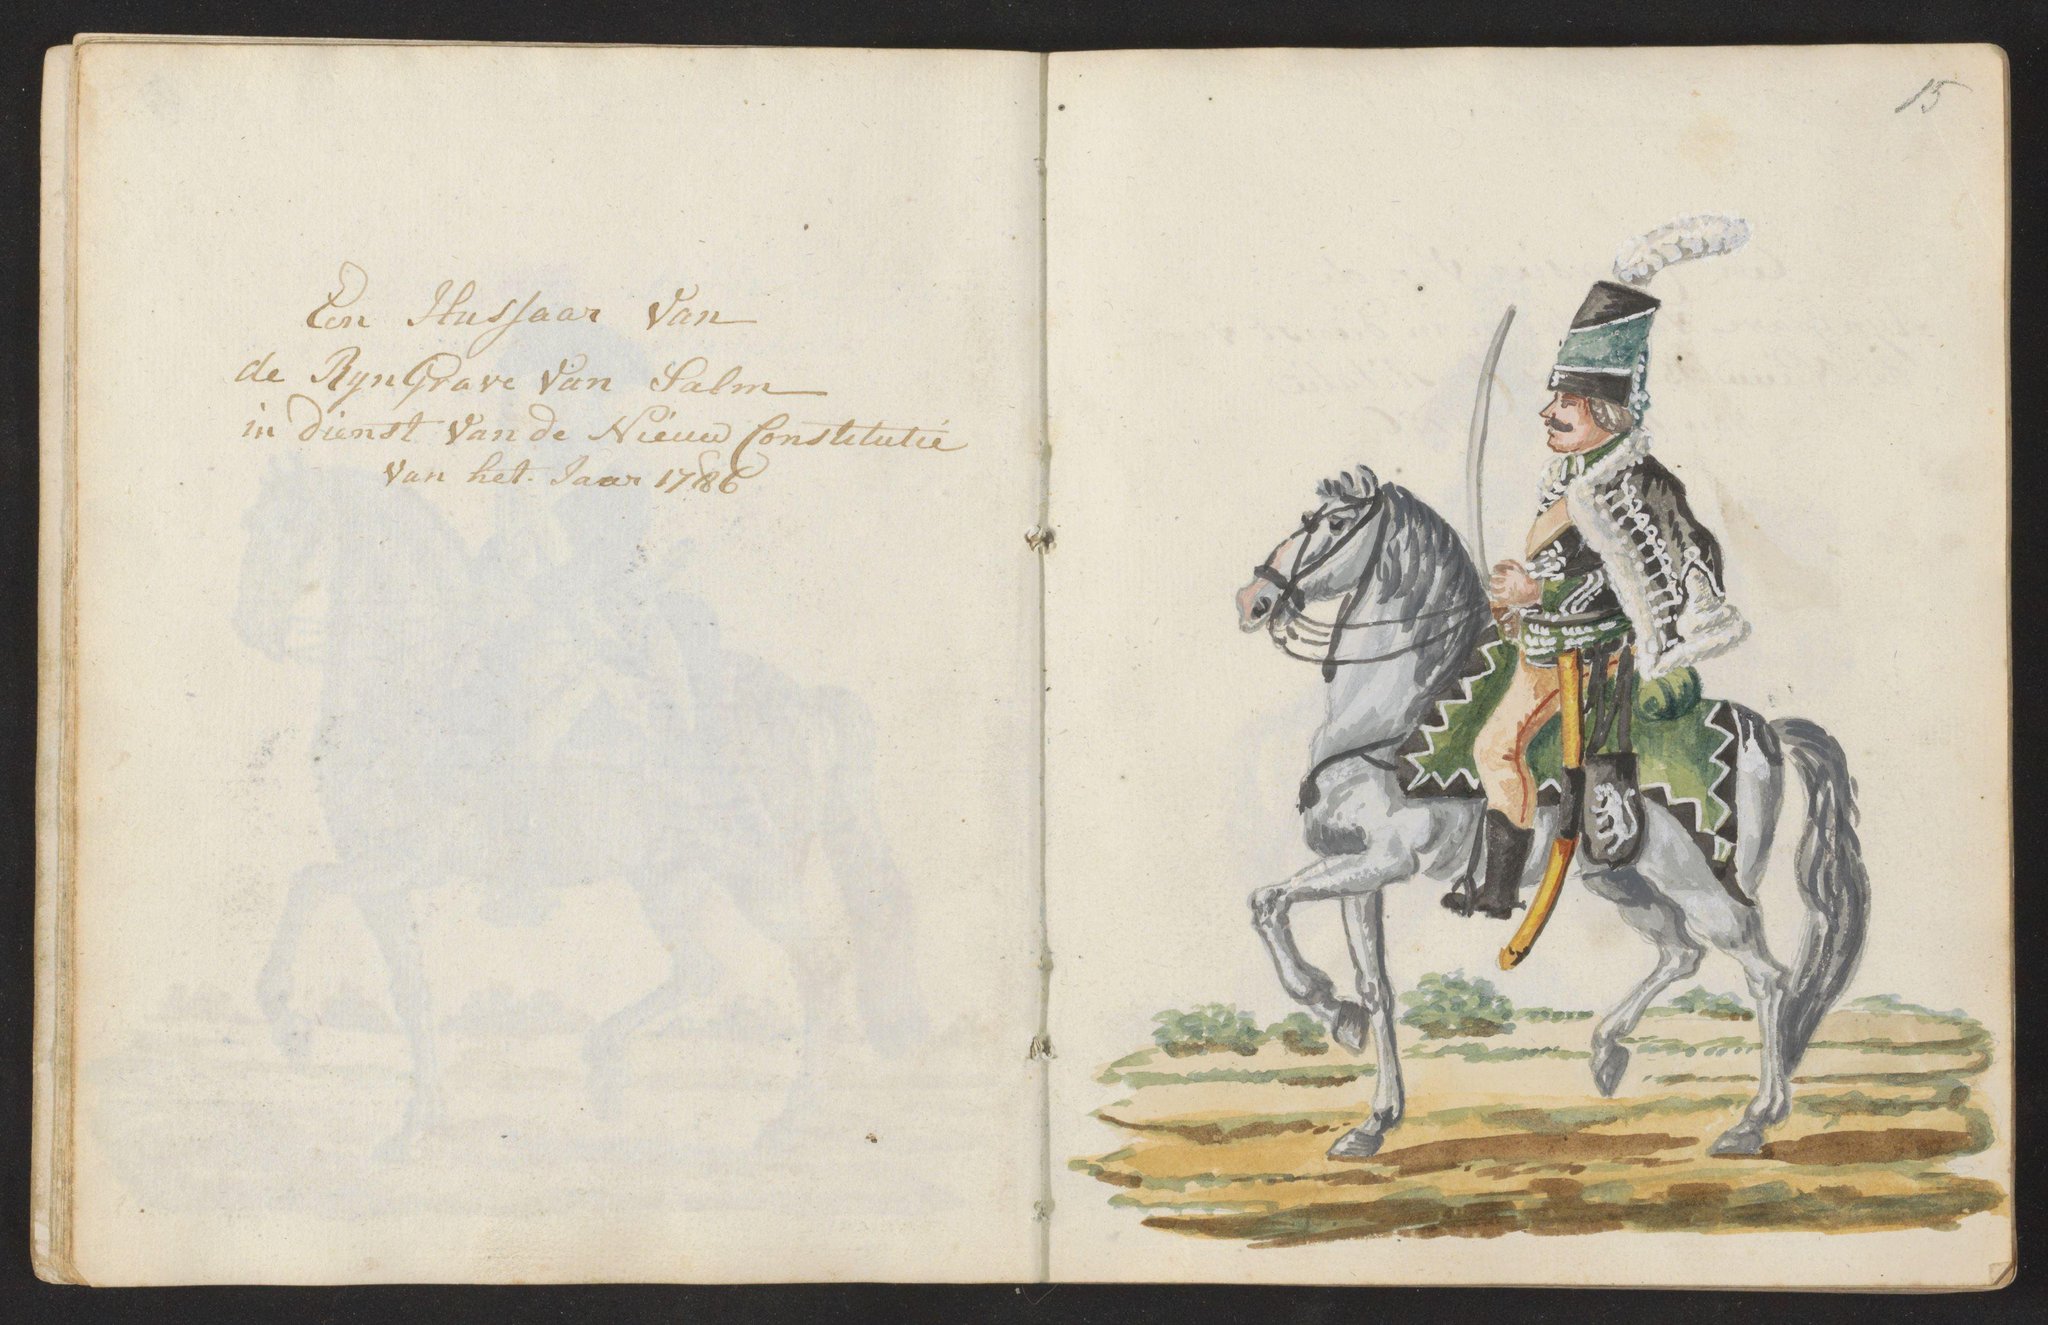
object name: drawing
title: Huzaar van de Rijngraaf van Salm in 1786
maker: s.g. casten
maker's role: draughtsman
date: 1795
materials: paper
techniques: writing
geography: amsterdam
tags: rijngraaf van salm frederik iii, (military) uniforms (+ cavalry, horsemen), patriots (1780-1795)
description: Het uniform van de huzaren van de Rijngraaf van Salm in 1786. Onderdeel van het tweede hoofdstuk over de nieuwe uniformen in de periode 1783-1787. In het schetsboek met gekleurde tekeningen van de uniformen van militairen en leden van de schutterij uit de periode 1770 tot 1795-1796.